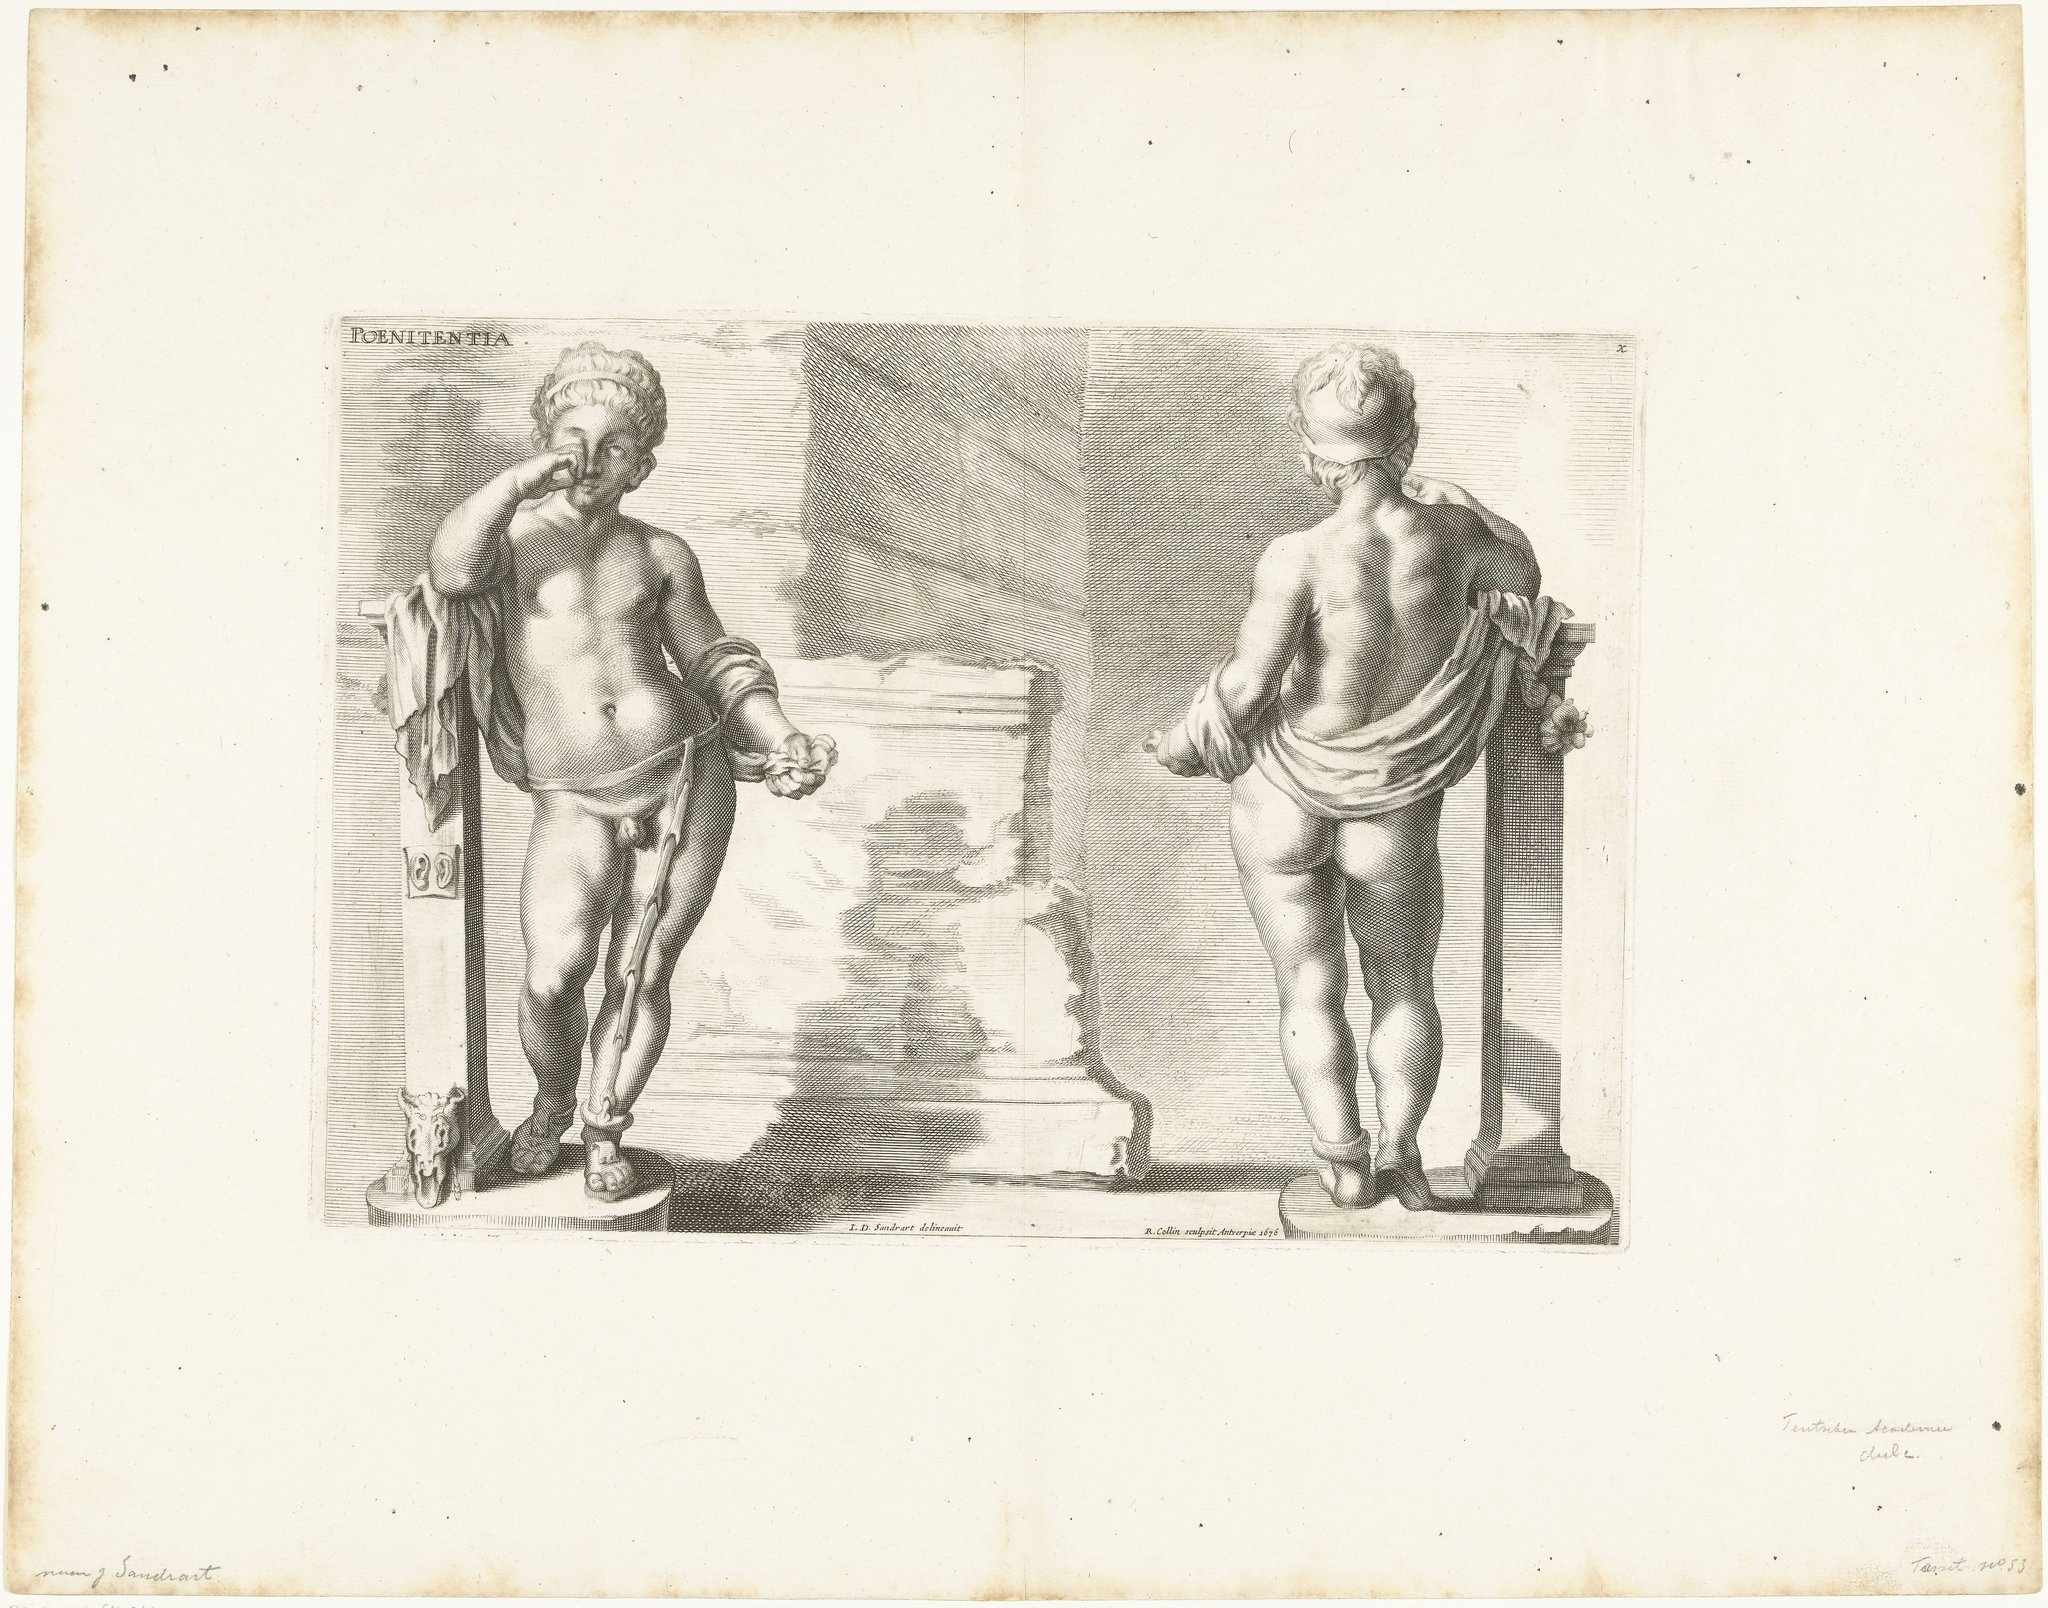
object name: print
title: Poenitentia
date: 1676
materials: paper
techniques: engraving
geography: antwerp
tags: penitence, repentance; 'penitenza', 'pentimento', 'pentimento de'peccati', 'purgatione de peccati' (ripa), piece of sculpture, reproduction of a piece of sculpture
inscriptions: collector's mark: Lugt 2228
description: Voor- en rugaanzicht van een beeld van een naakte jongen met boeteriem om zijn middel. De jongen leunt op een zuil en wrijft met zijn hand in zijn oog. Tegen de zuil aan leunt een schedel van een dier, in het midden van de zuil hangt een afbeelding van twee oren.